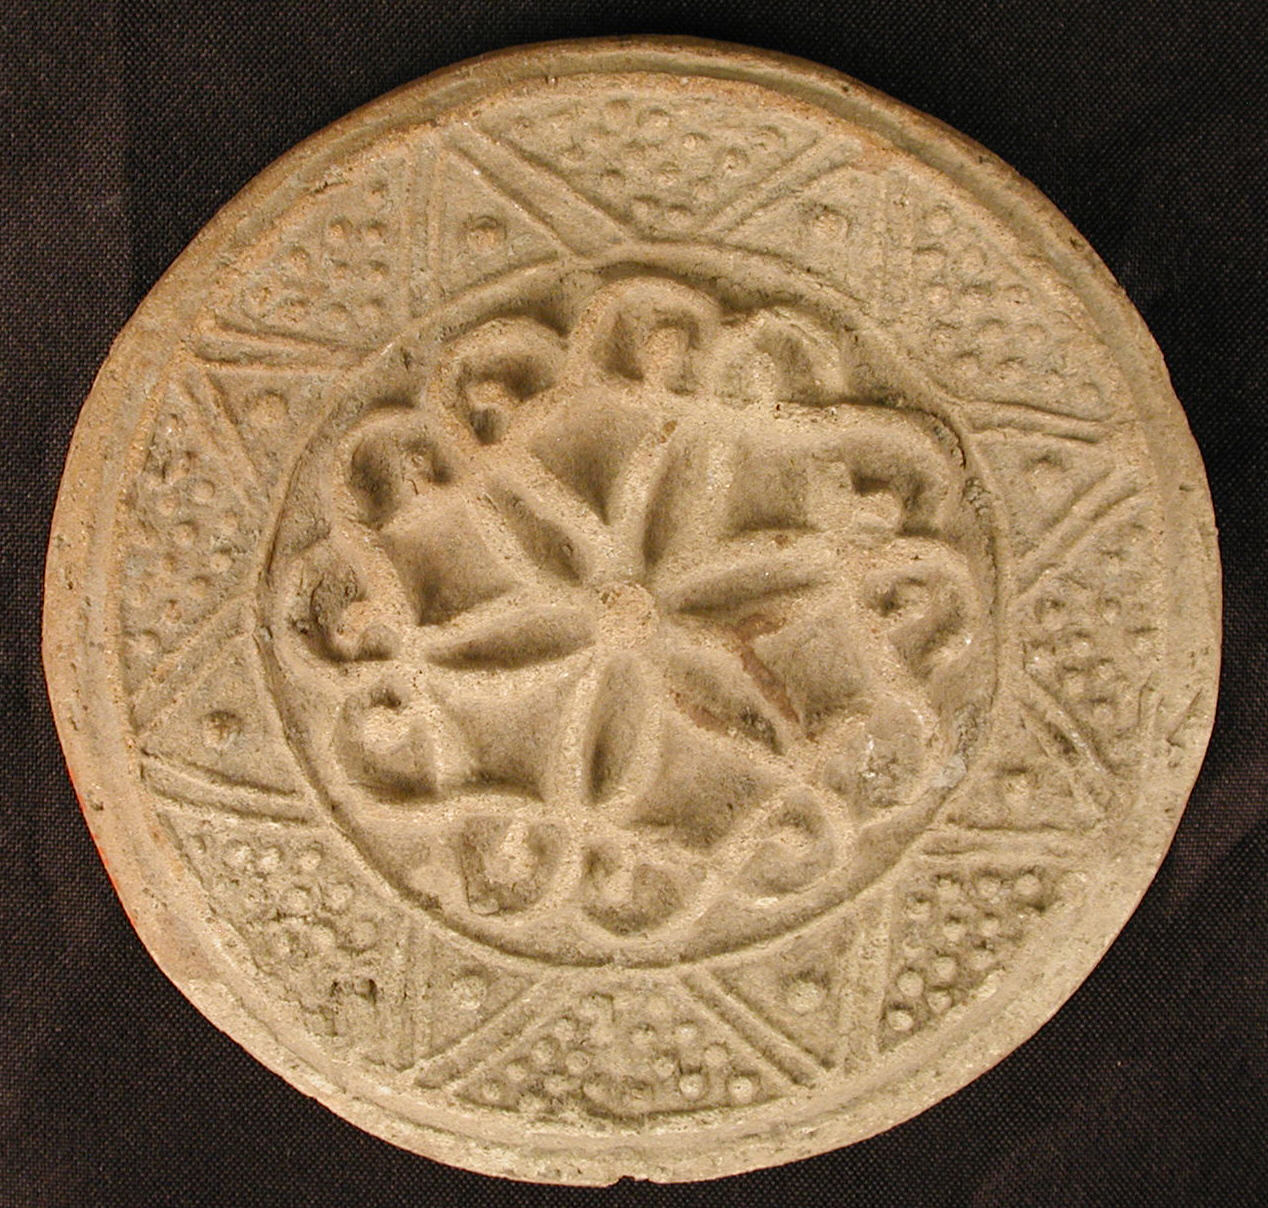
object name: bath scraper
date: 1101-1300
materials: earthenware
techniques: molding, relief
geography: iran